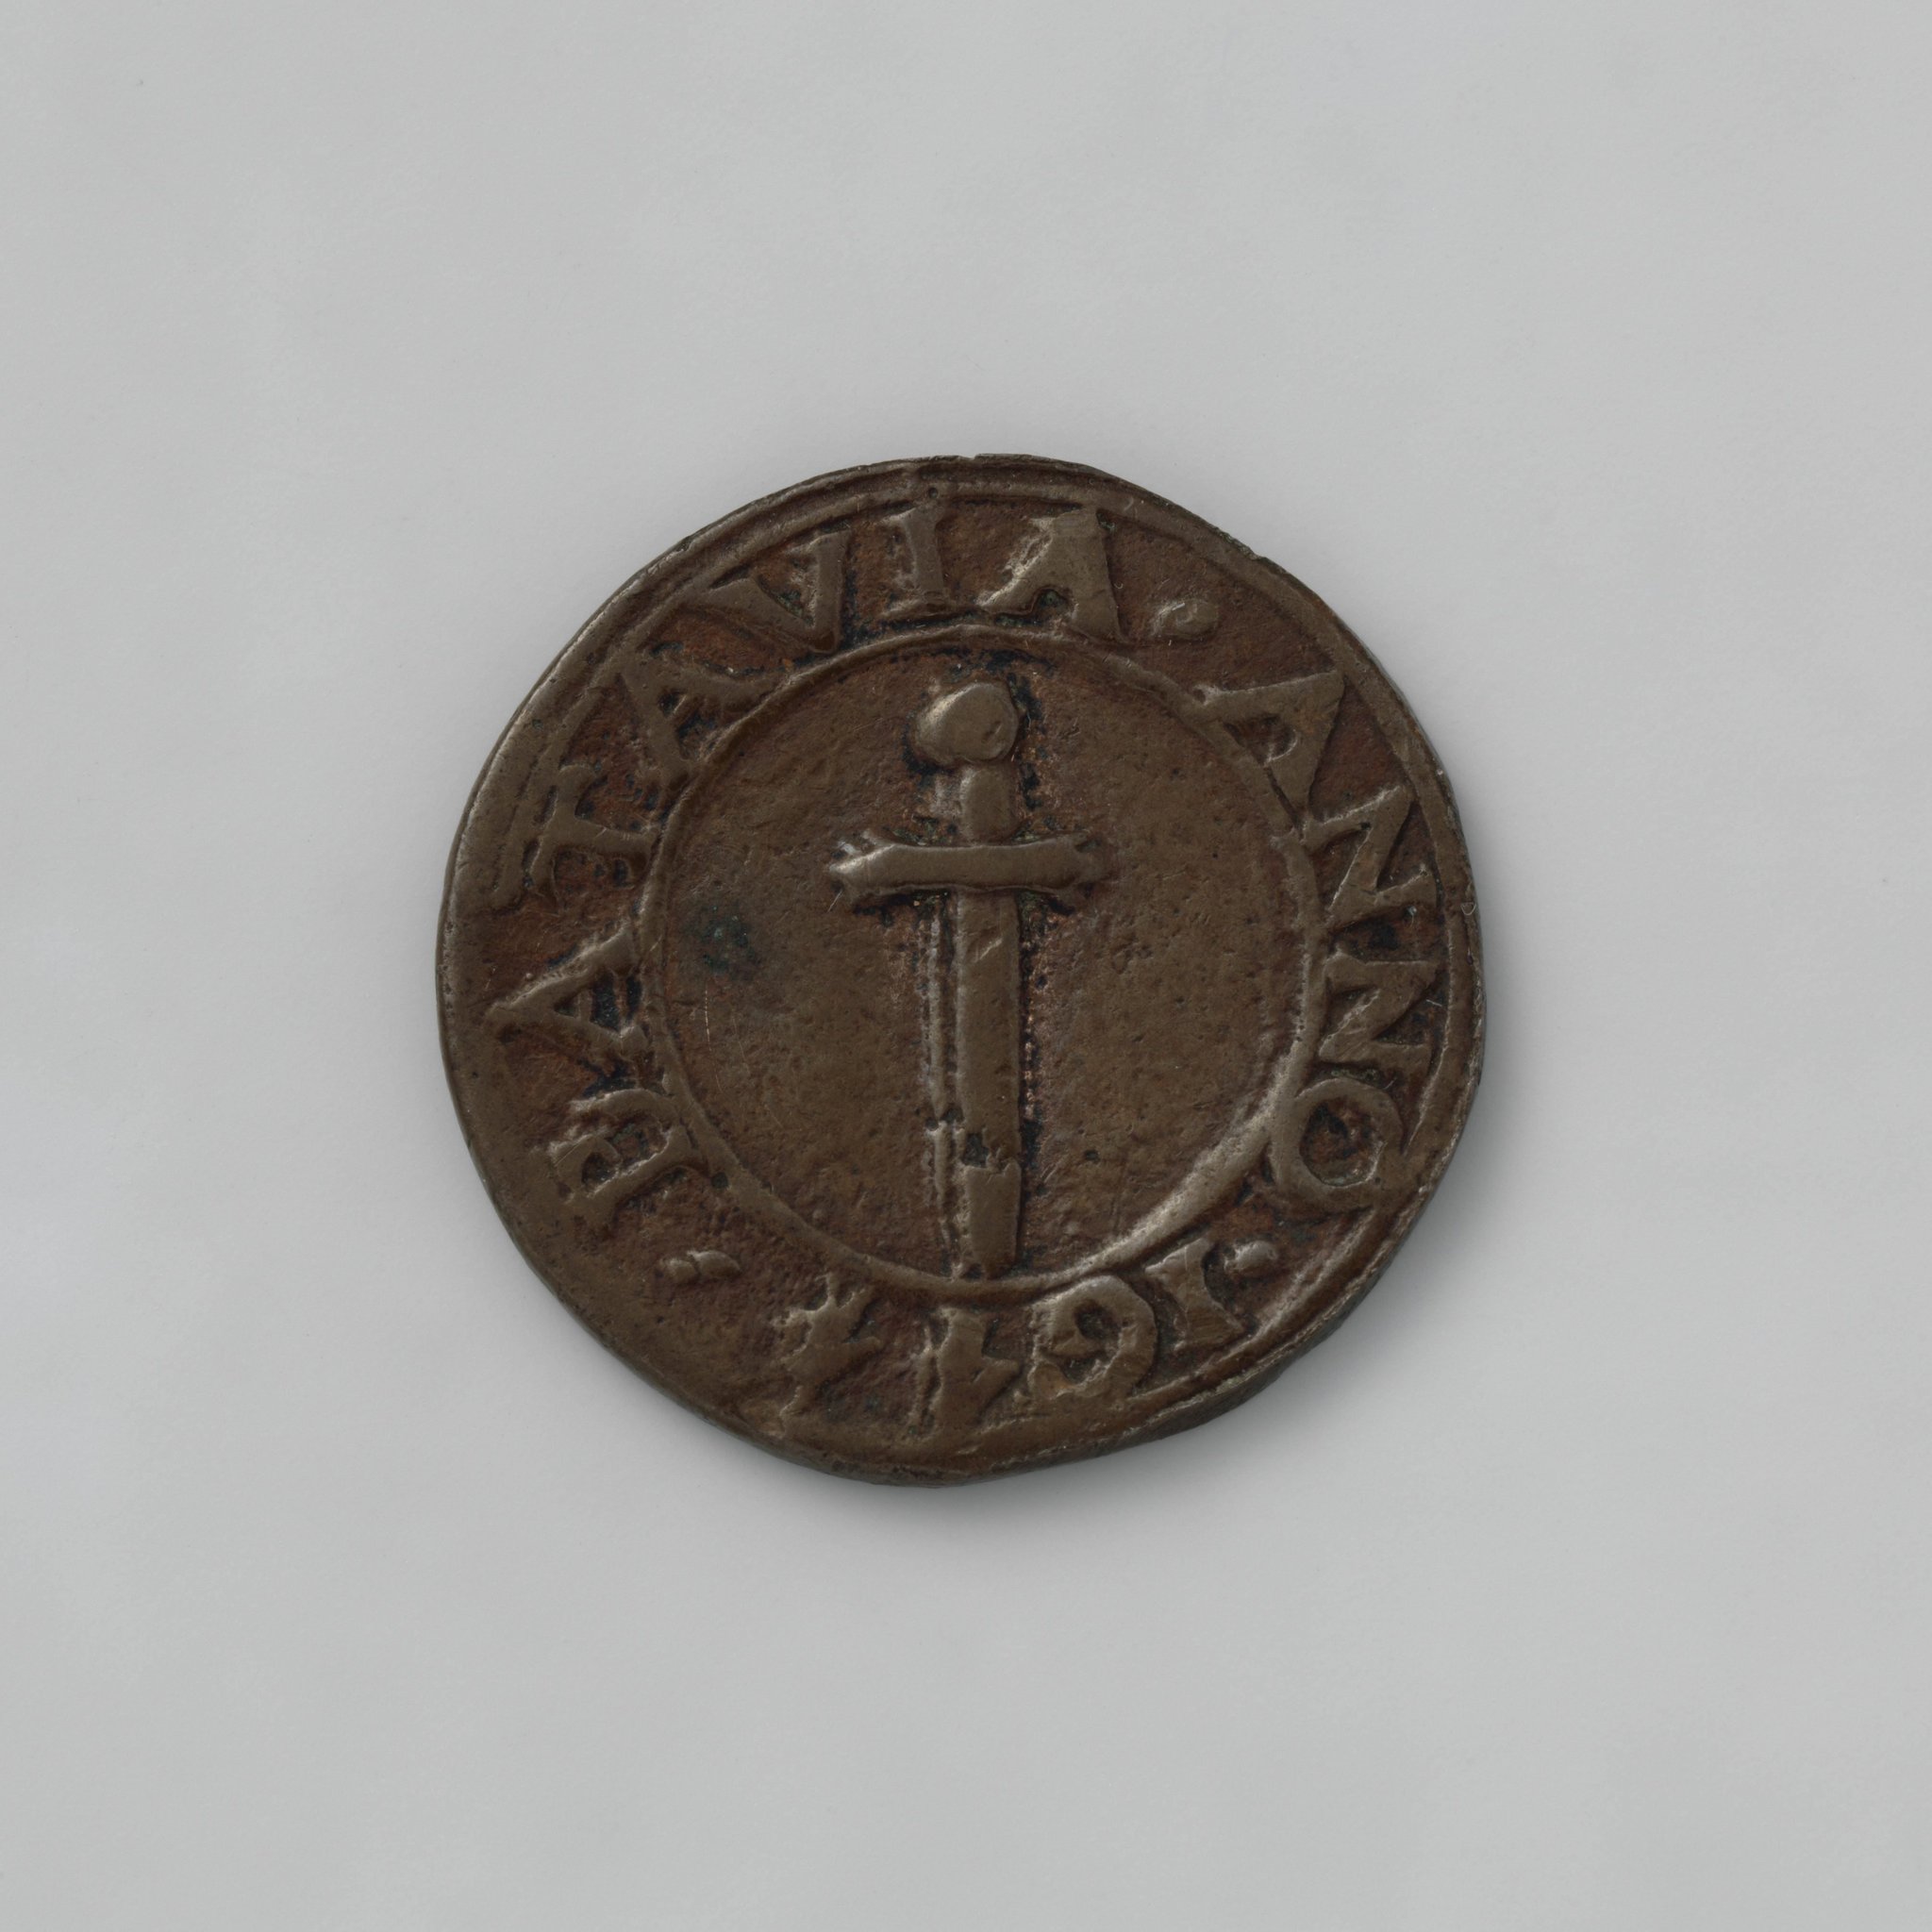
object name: halve stuiver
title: VOC, ½ stuiver, 1644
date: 1644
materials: copper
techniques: striking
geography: batavia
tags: verenigde oostindische compagnie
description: Koperen noodmunt. Voorzijde: naar beneden gericht zwaard. Jaartal in omschrift. Keerzijde: monogram van de VOC, waarboven waarde-aanduiding 1/2 st. Gladde rand.